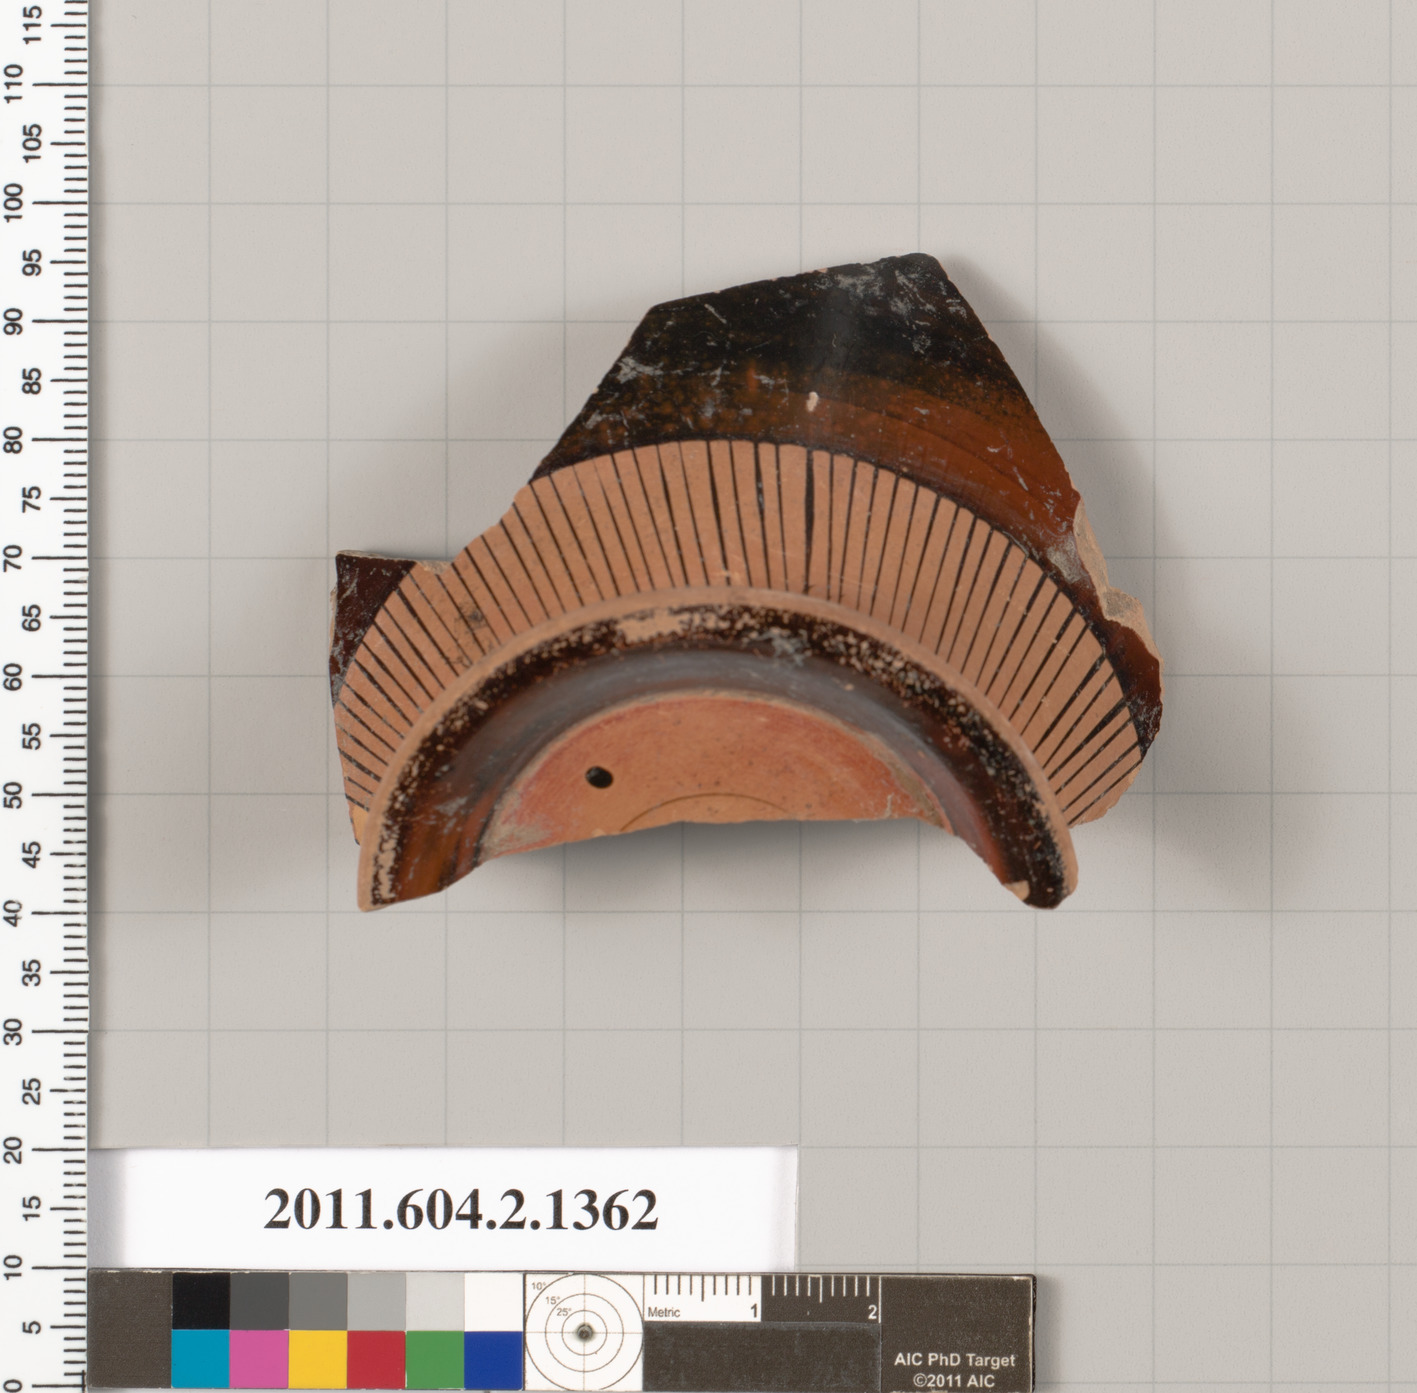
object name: skyphos fragment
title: Terracotta fragment of a skyphos (deep drinking cup)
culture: greek, attic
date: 470-460 BCE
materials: terracotta